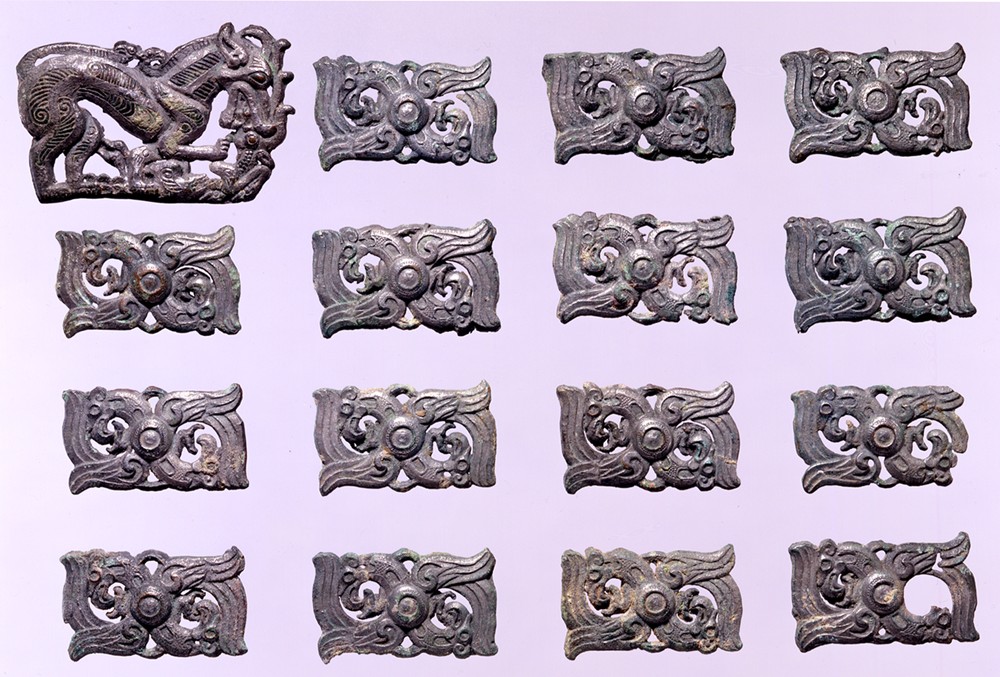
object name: belt ornament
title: Sixteen Belt Ornaments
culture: northwest chinese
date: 400-301 BCE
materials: bronze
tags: animals